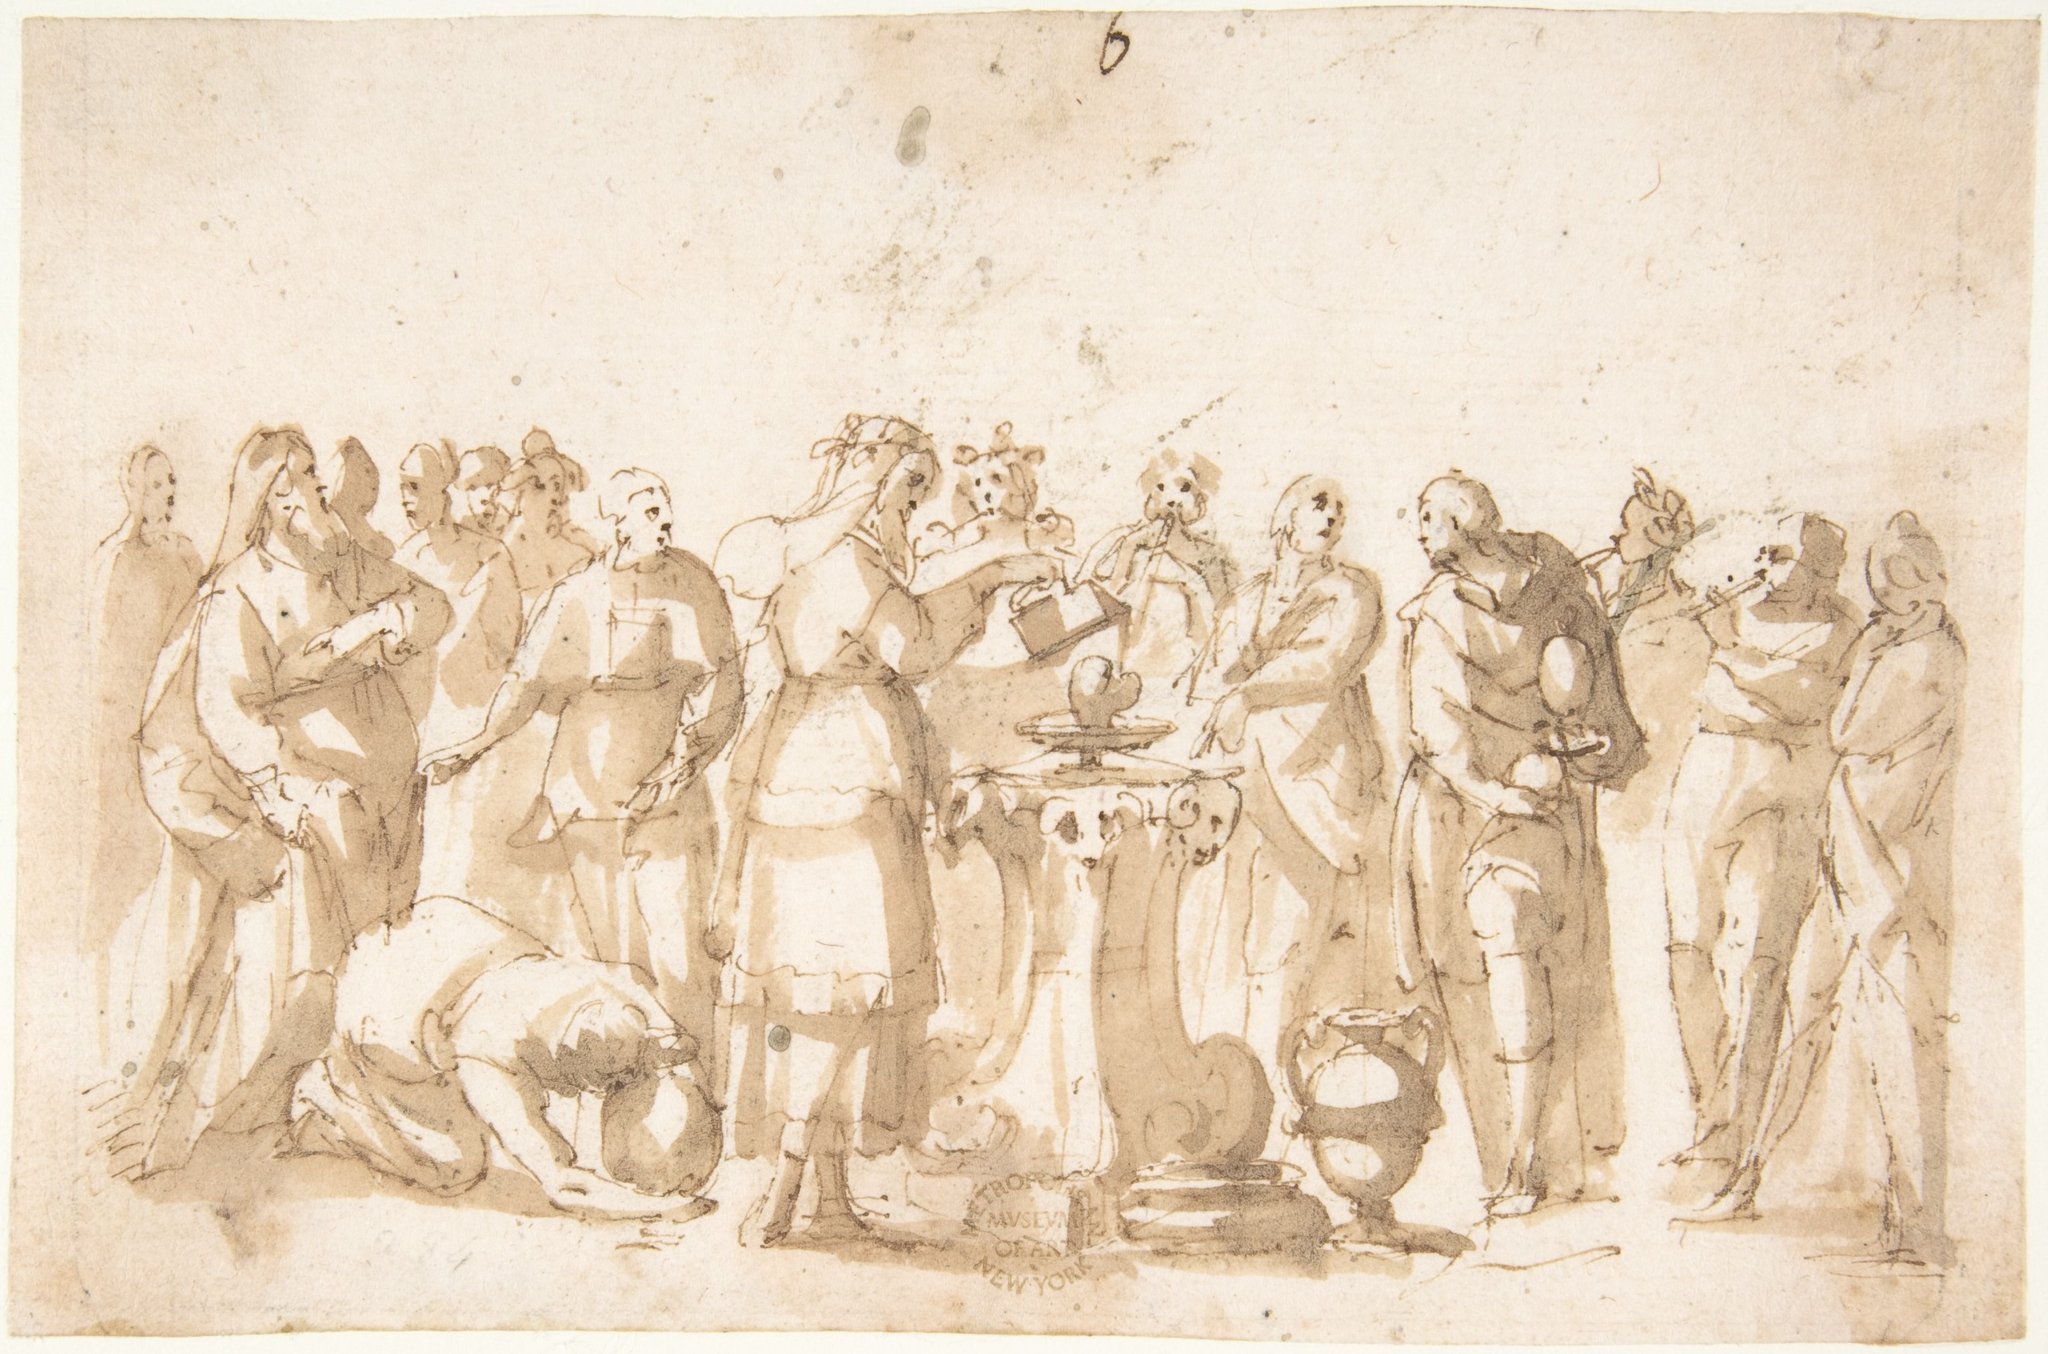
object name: drawing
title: Scene of Sacrifice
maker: francesco allegrini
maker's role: artist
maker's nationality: italian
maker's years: 1615-1679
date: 1624-1663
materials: chalk, ink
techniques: brush, pen, wash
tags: men,women